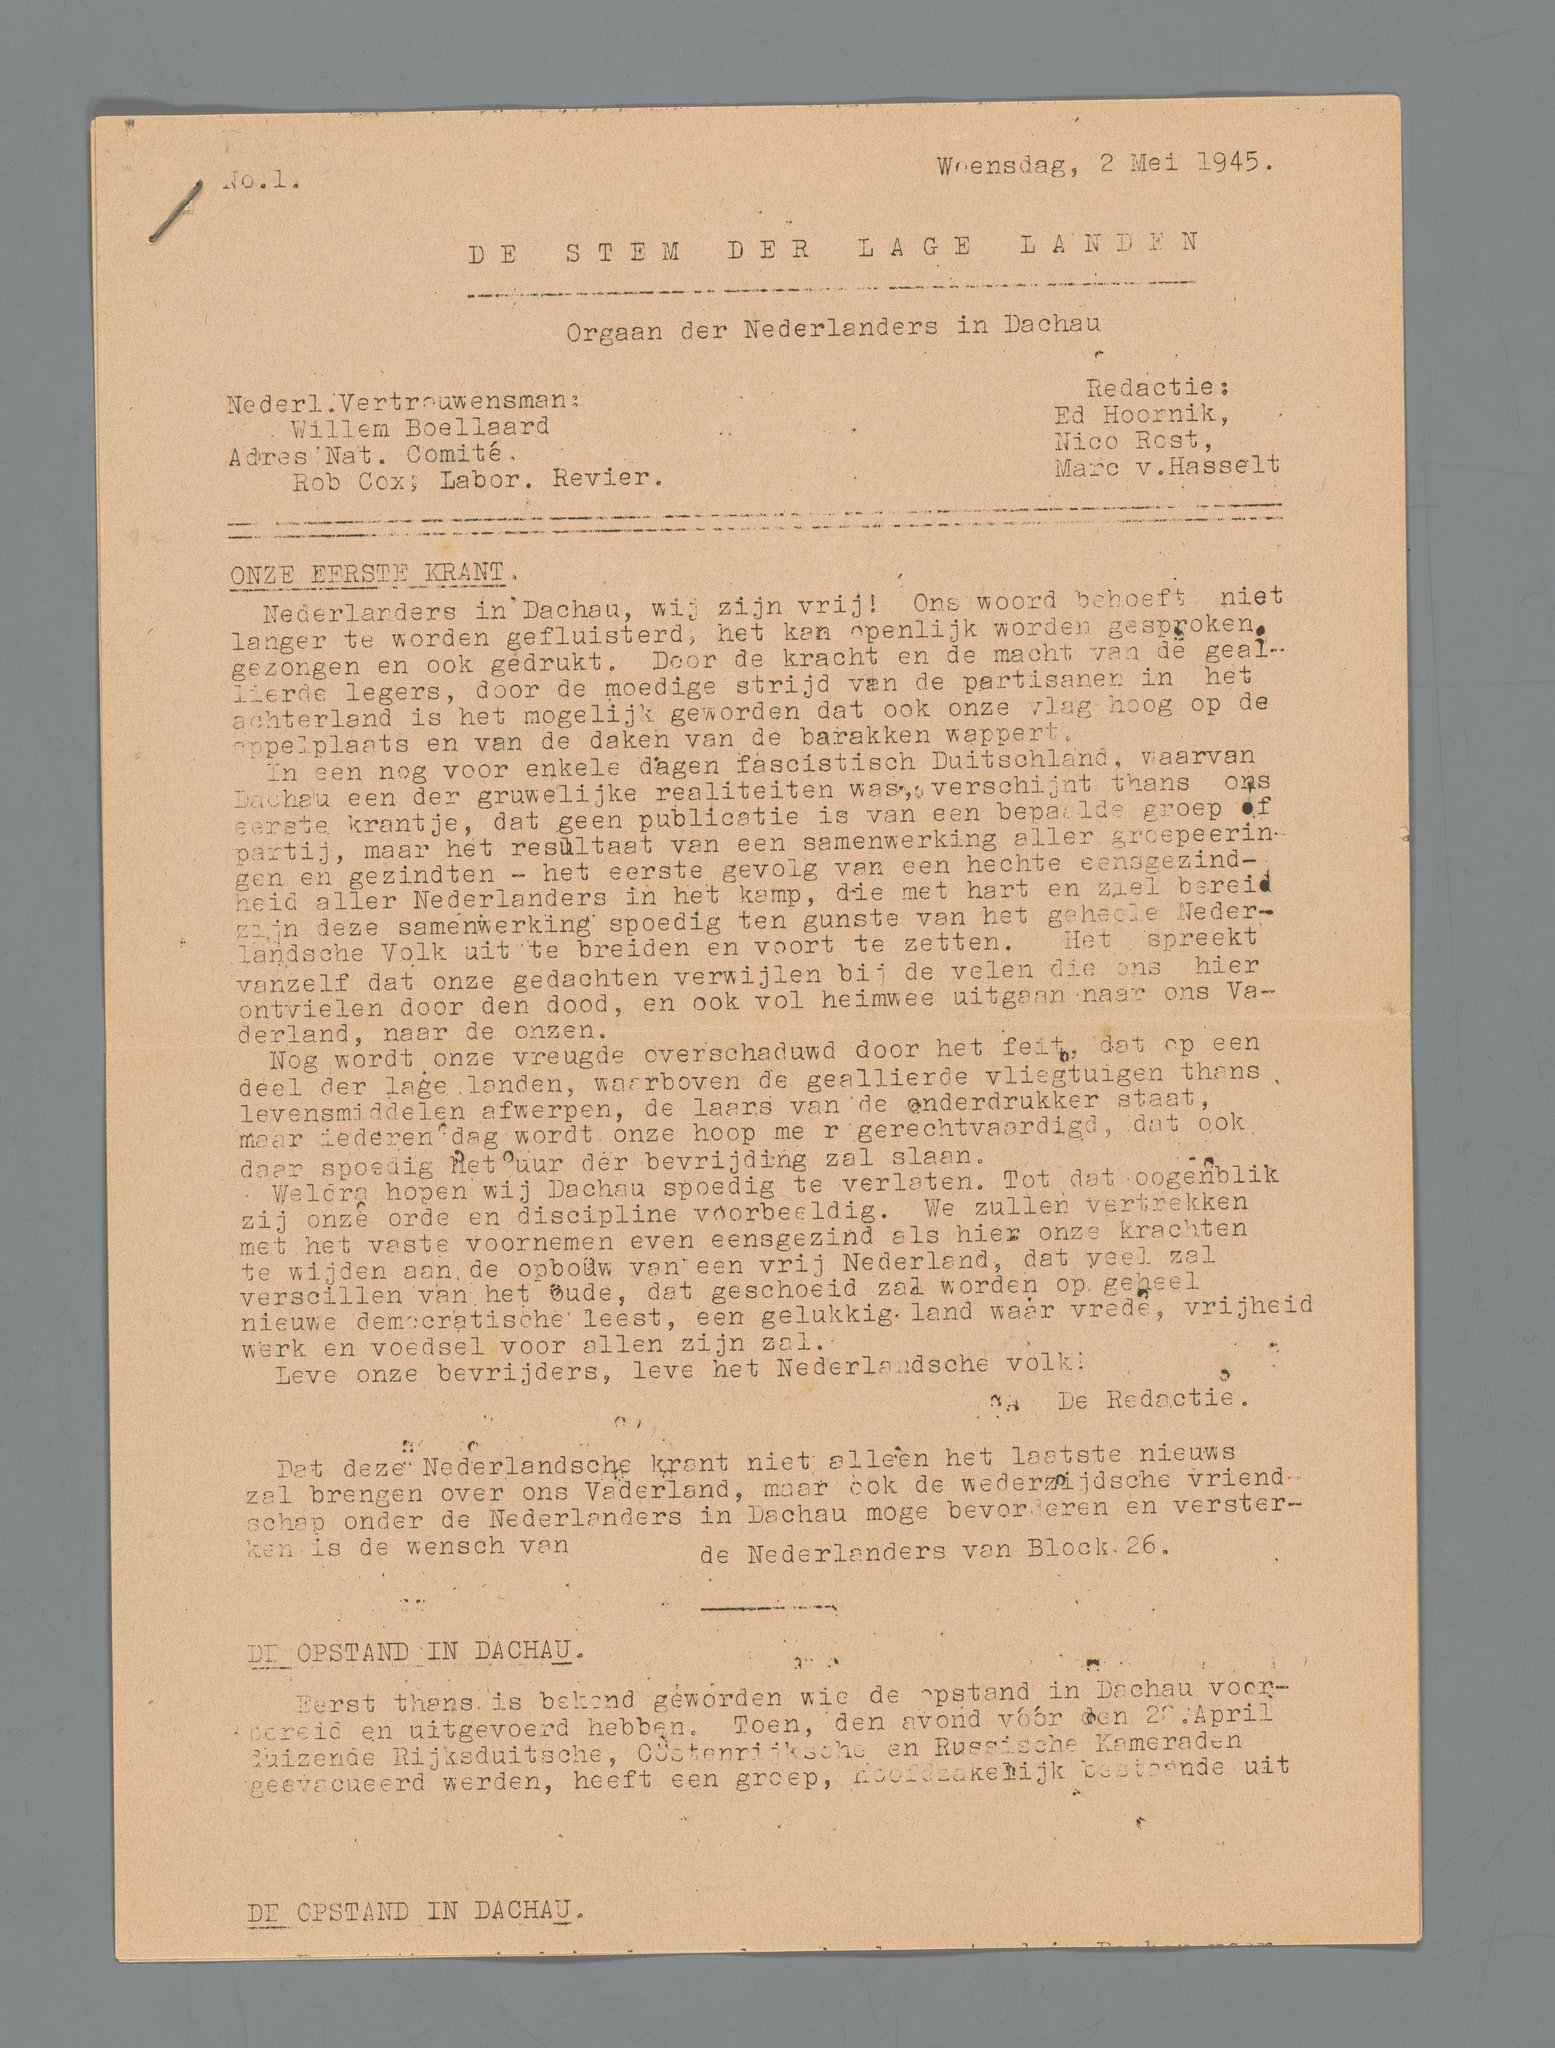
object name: newspaper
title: De stem der lage landen, nr. 1, 2 mei 1945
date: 1945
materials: paper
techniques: mimeography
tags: etienne françois marie bouter, dachau, tweede wereldoorlog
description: Gestencilde krant 'De stem der lage landen / Orgaan der Nederlanders in Dachau', aflevering nr. 1, 2 mei 1945. Twee bladen bedrukt aan beide zijden. Verschenen onder redactie van Ed Hoornik, Nico Rost en Marc van Hasselt.